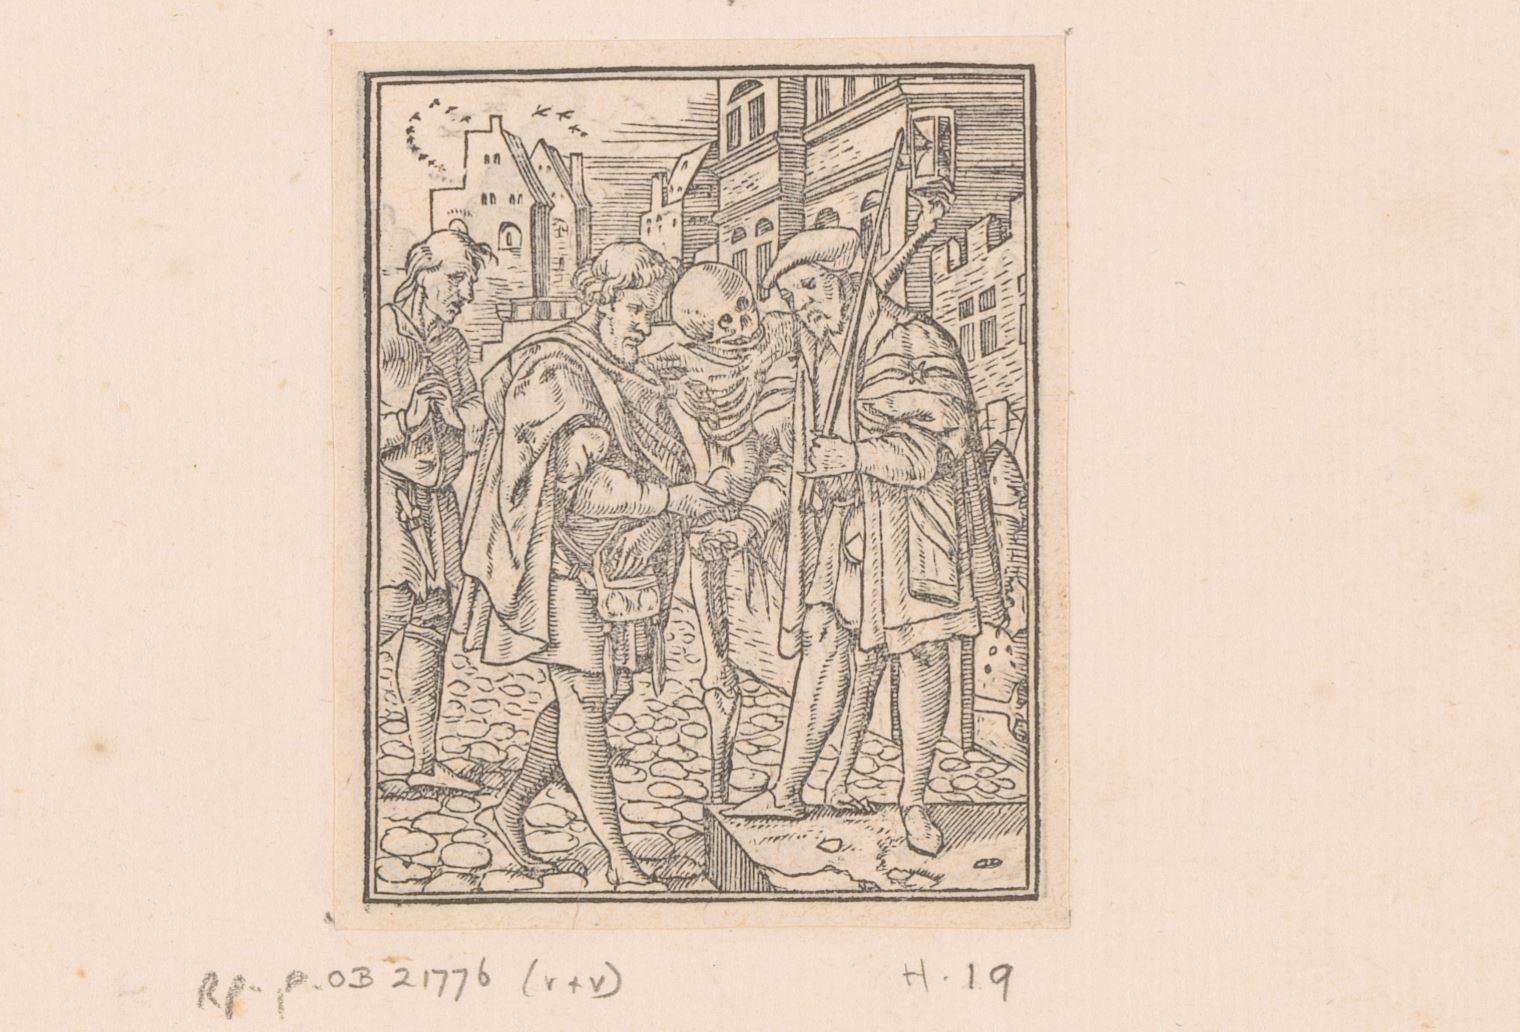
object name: print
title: Kopieën naar Holbeins Dodendans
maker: Anonymous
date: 1547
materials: paper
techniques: woodcut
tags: dance of death; death together with one or more human beings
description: Kopie van een prent van Hans Holbein de jongere uit 1538, voor het eerst gepubliceerd in: Imagines mortis (...). Lyon: Johannes Frellon, 1547.